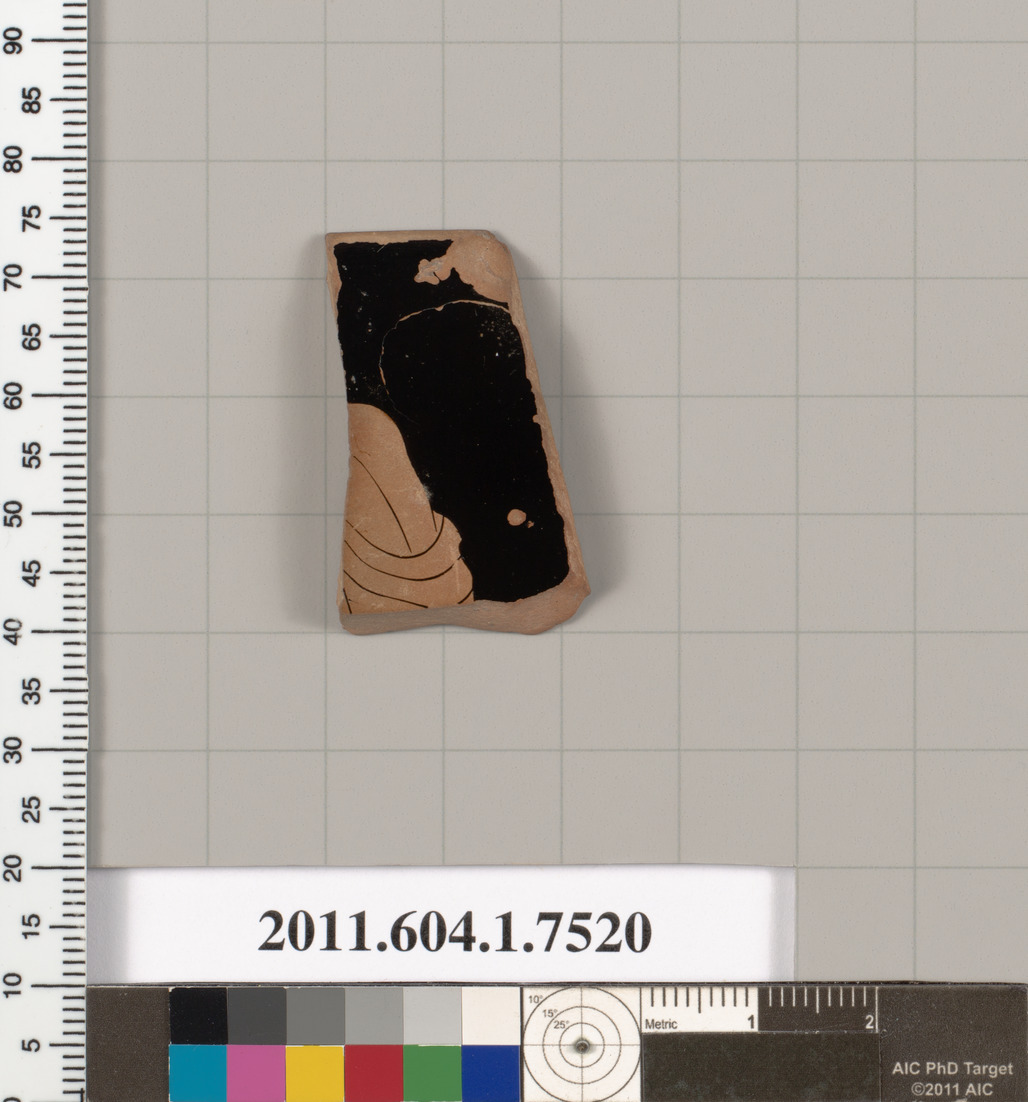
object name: kylix fragment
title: Terracotta rim fragment of a kylix (drinking cup)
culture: greek, attic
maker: euaion painter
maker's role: artist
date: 460-450 BCE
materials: terracotta